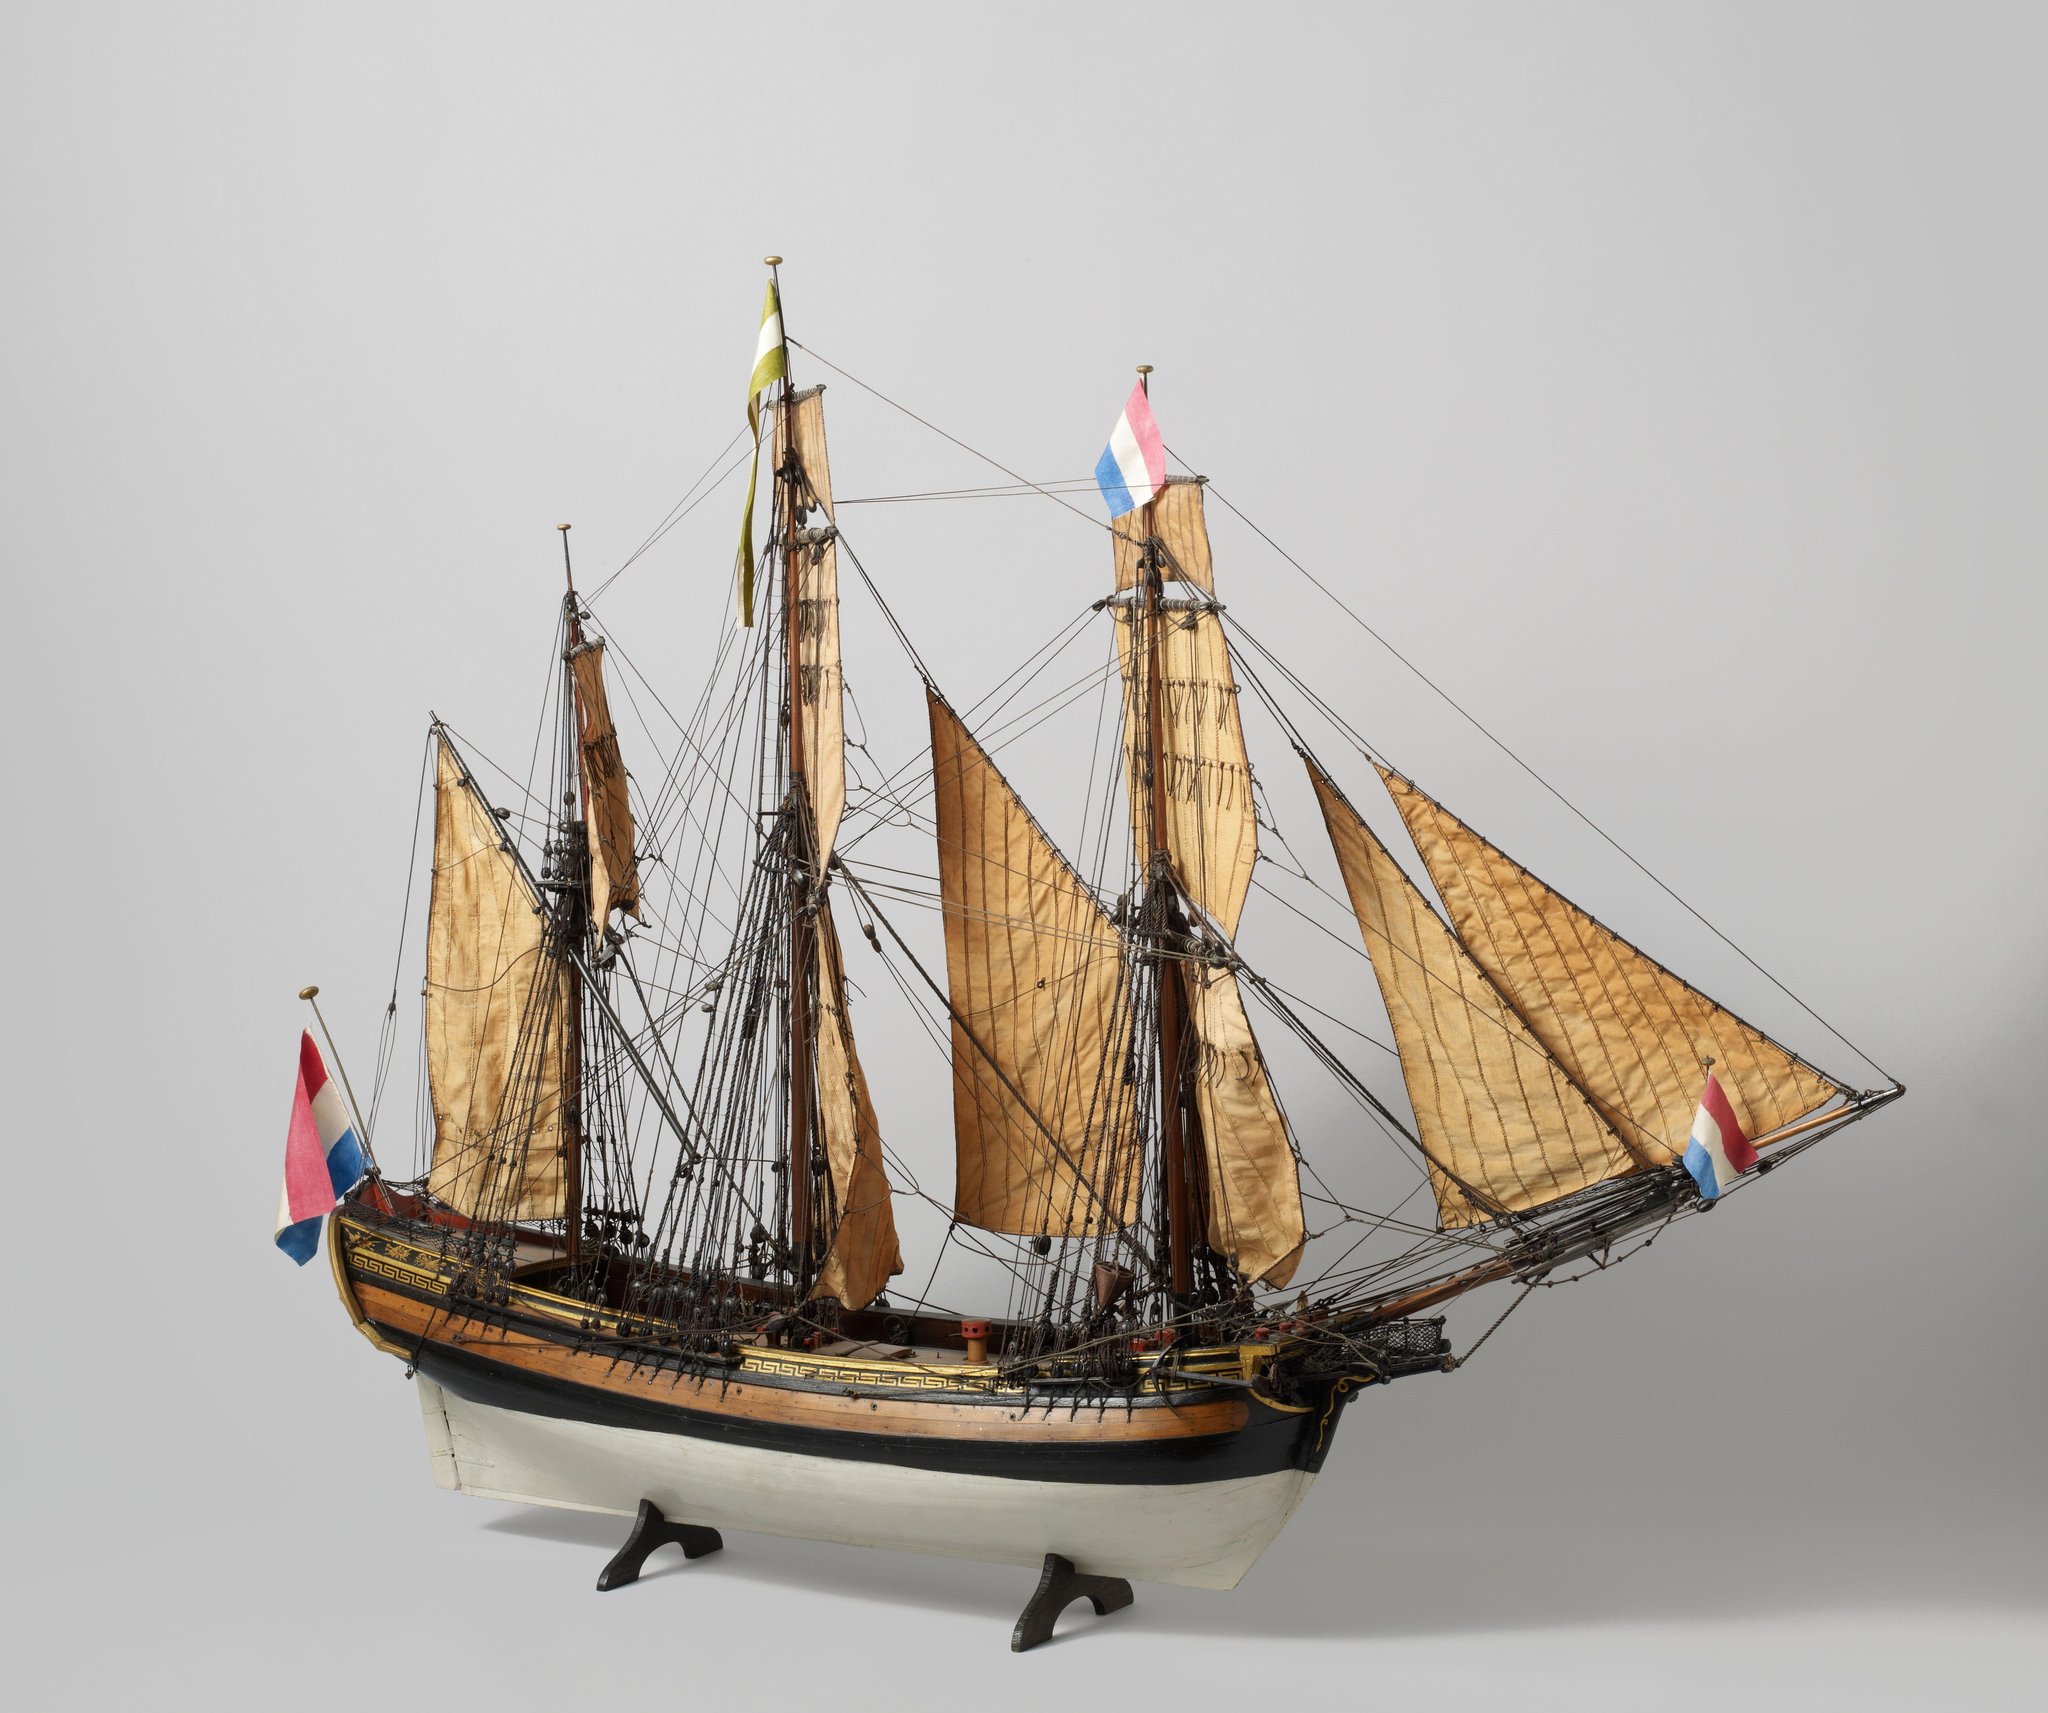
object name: ship model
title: Model of a Polacre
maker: Anonymous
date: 1815-1850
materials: brass, fiber, textile, wood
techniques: polychromy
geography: netherlands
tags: ship-model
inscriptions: inscription, on the stern: ‘DEDALUS’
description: Het Rijkswapen is een aanwijzing voor een datering van het model in of na 1815. De Daedalus is geregistreerd in Lloyds Register of Shipping van 1819. Zij zou zijn gebouwd in Emden (Duitsland) in 1806 als ééndeks schoener. Zij voer op de lijnen Londen-Amsterdam en Londen-Bremen. In 1809 stond zij te boek als galjoot, in 1810 als schip, in 1811 als galjoot en in 1816 als schoener.